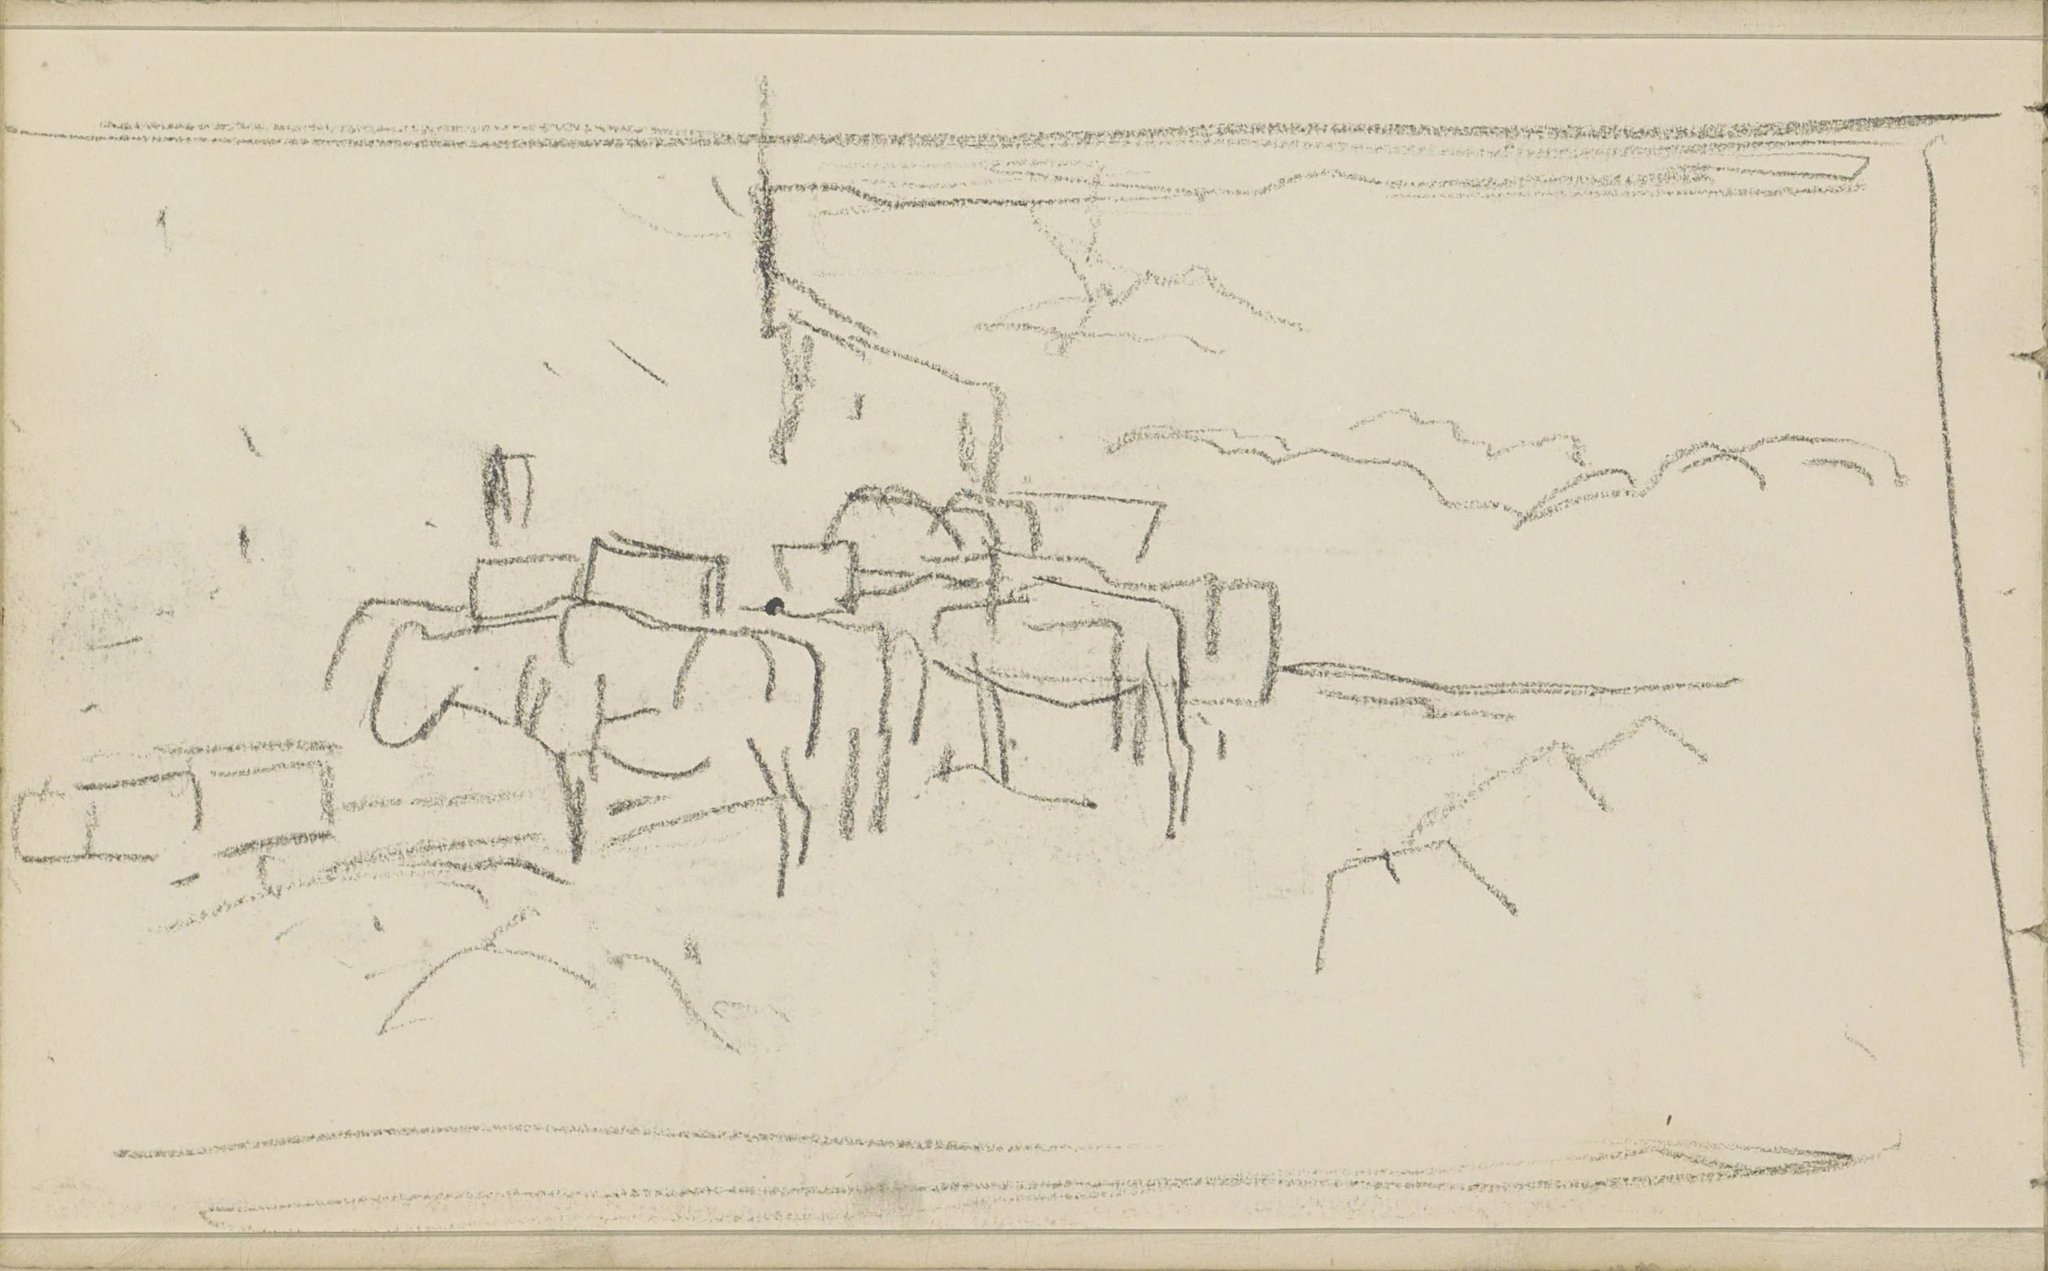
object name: sketchbook leaf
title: Gezadelde ezels op een rij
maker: anton mauve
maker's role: draughtsman, painter, print maker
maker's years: 1838-1888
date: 1848-1888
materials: chalk, paper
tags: ass, donkey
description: Blad 28 verso uit een schetsboek met 42 bladen.